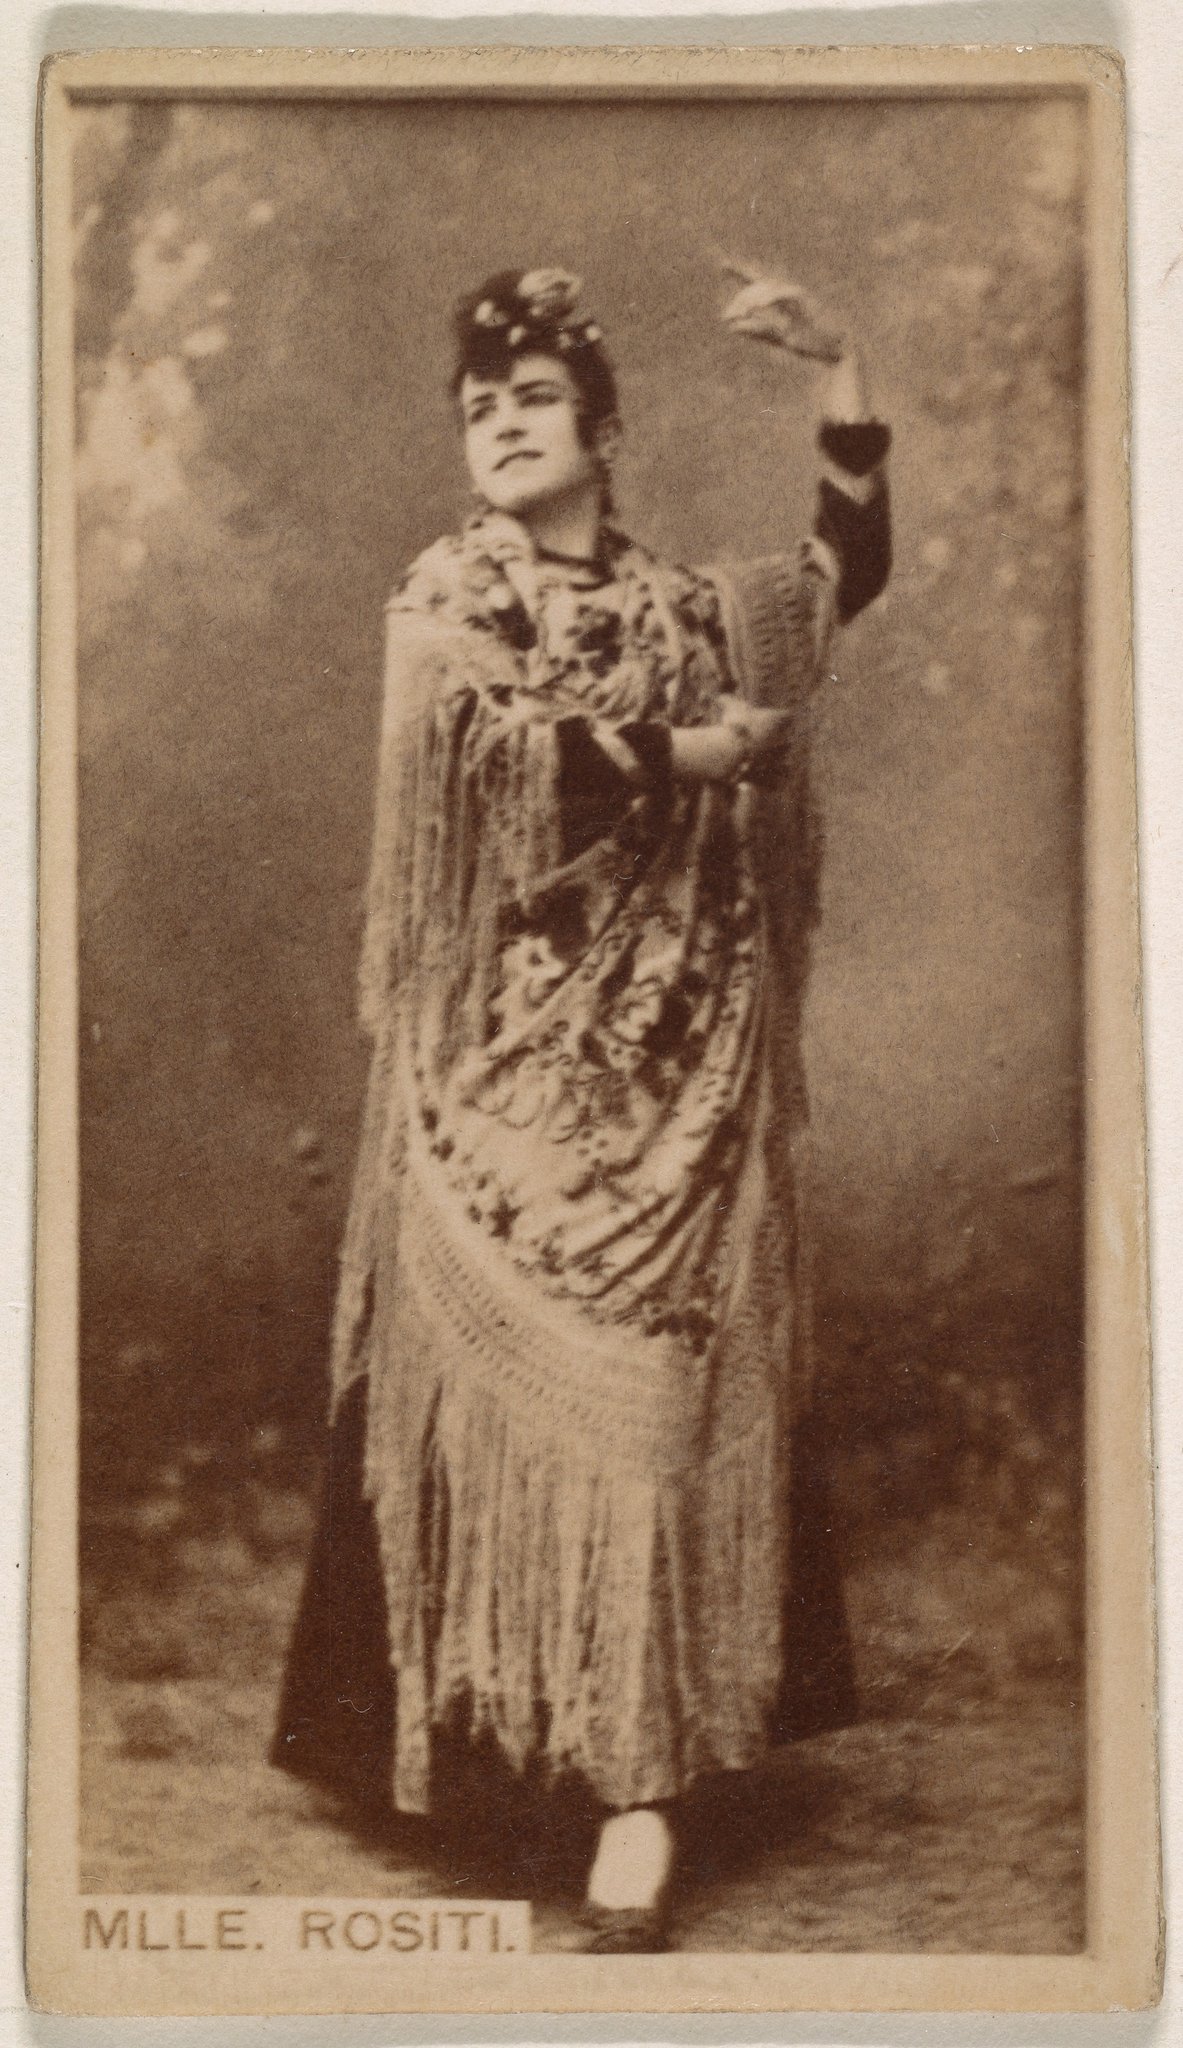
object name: photograph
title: Mlle. Rositi, from the Actresses series (N245) issued by Kinney Brothers to promote Sweet Caporal Cigarettes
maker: kinney brothers tobacco company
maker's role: publisher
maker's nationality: american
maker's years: 1869-2011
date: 1890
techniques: albumen silver print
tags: portraits,women,actresses